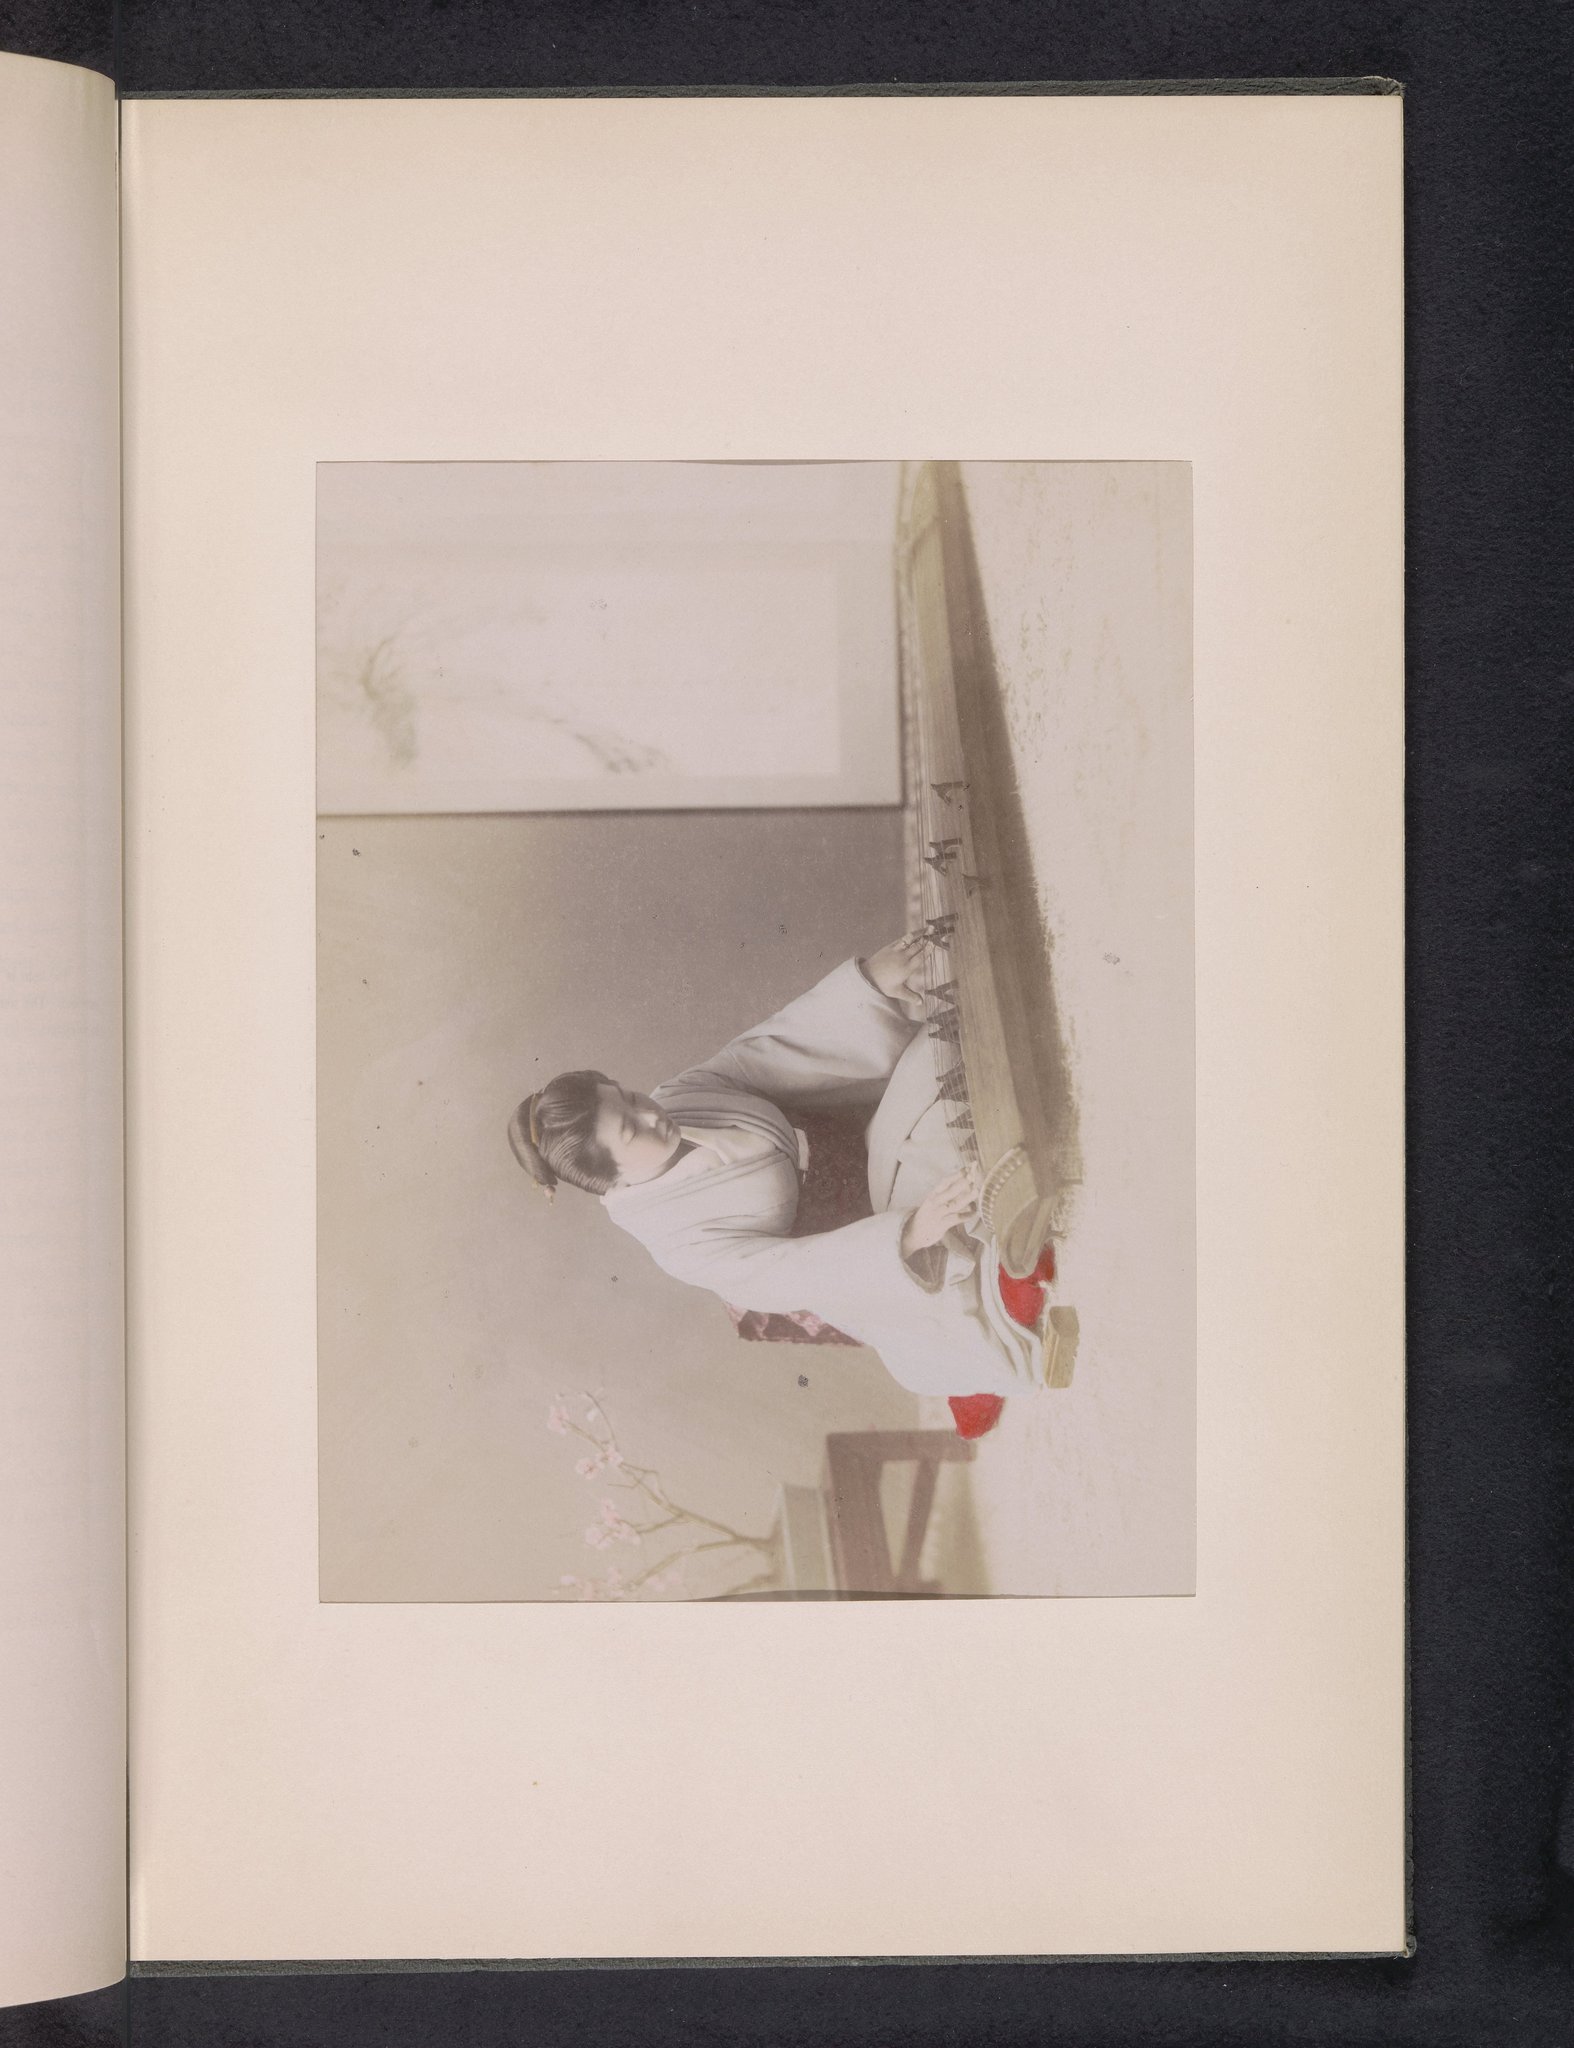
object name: page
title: Vrouw speelt de koto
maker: Anonymous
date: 1887-1897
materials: photographic support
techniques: albumen print, hand coloring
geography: japan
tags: one person playing string instrument (plucked), interior ~ representation of a building